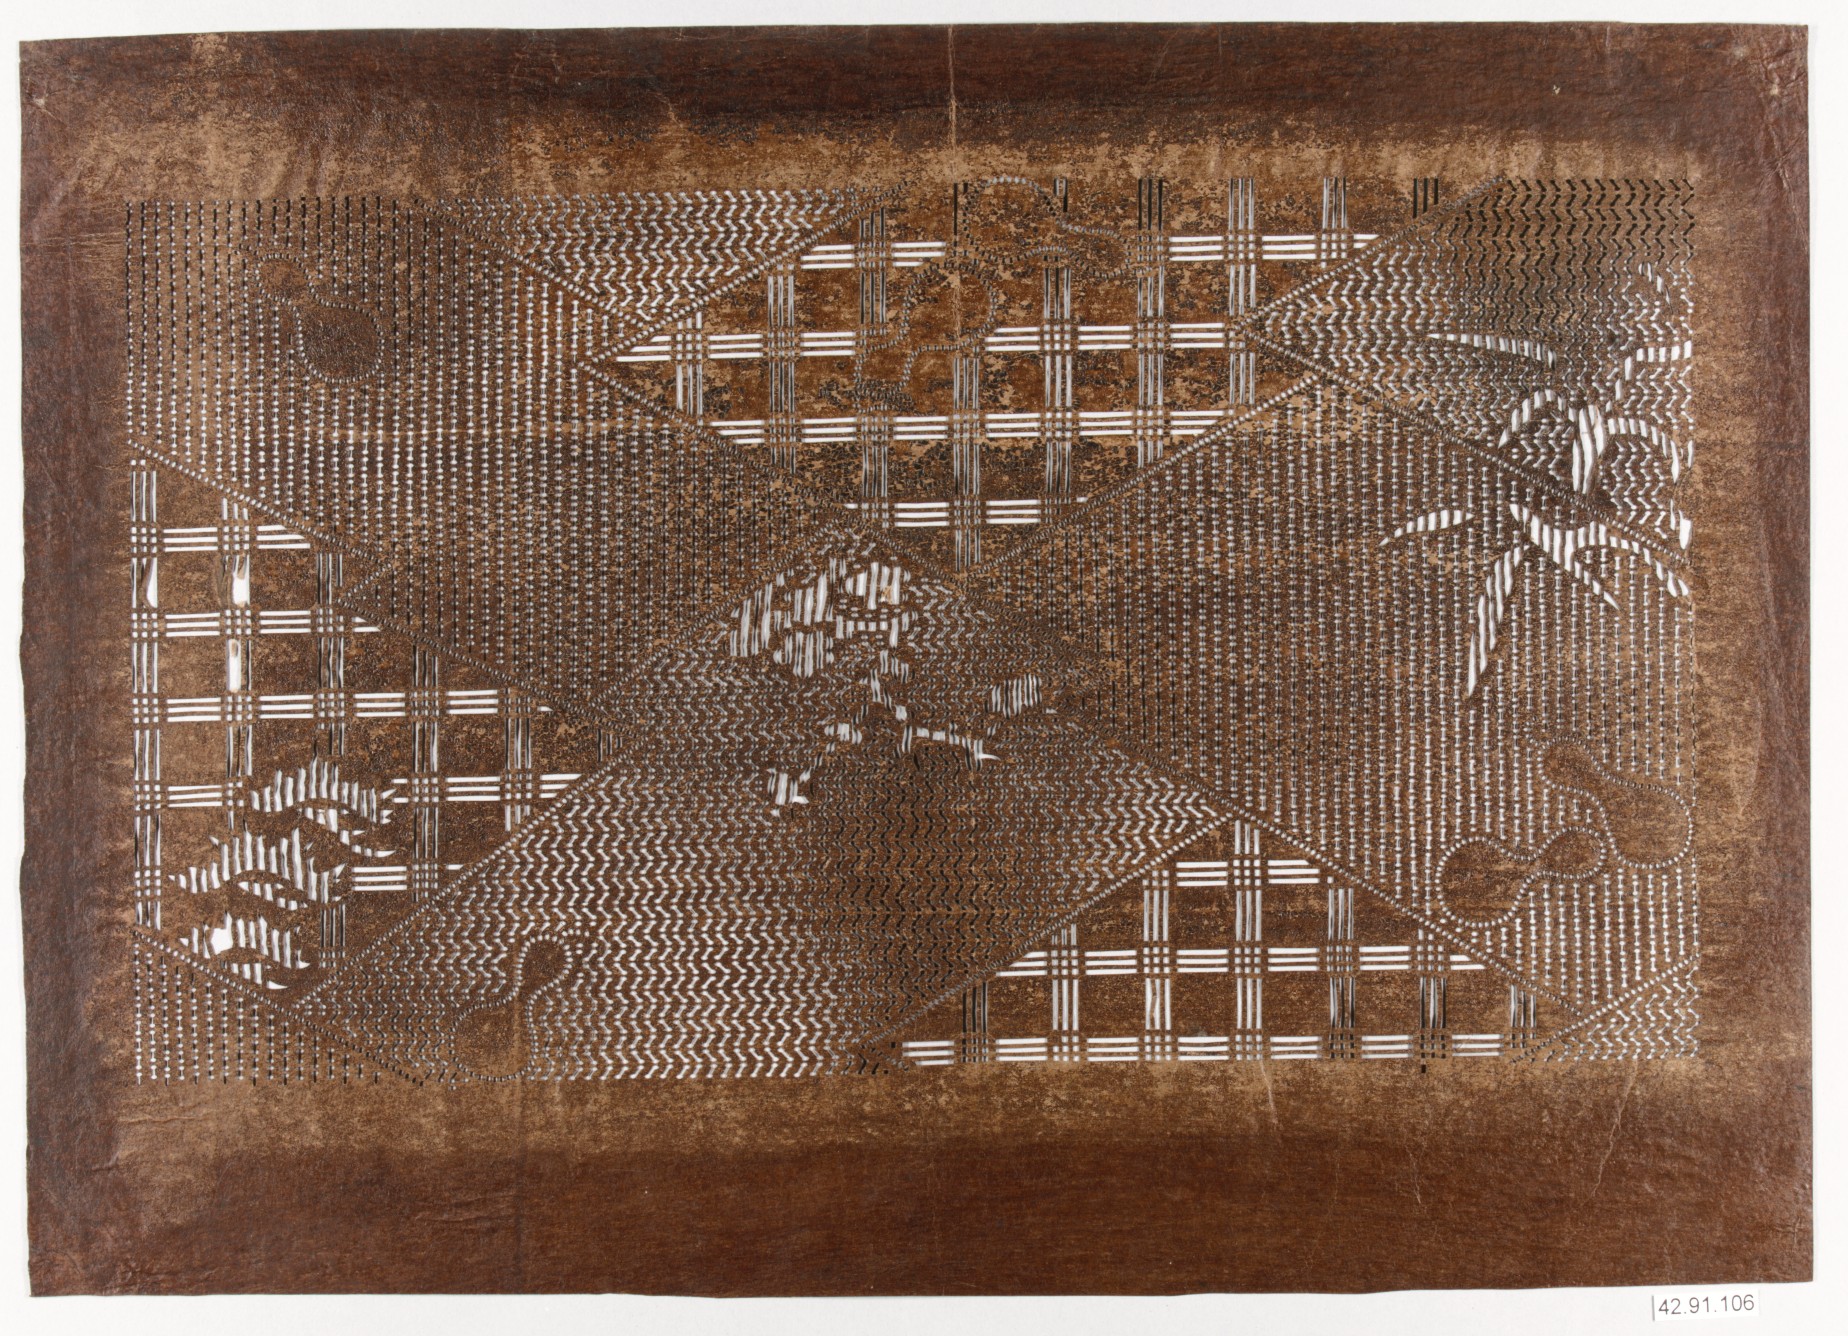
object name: stencil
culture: japanese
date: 1801-1900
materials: paper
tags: gourds